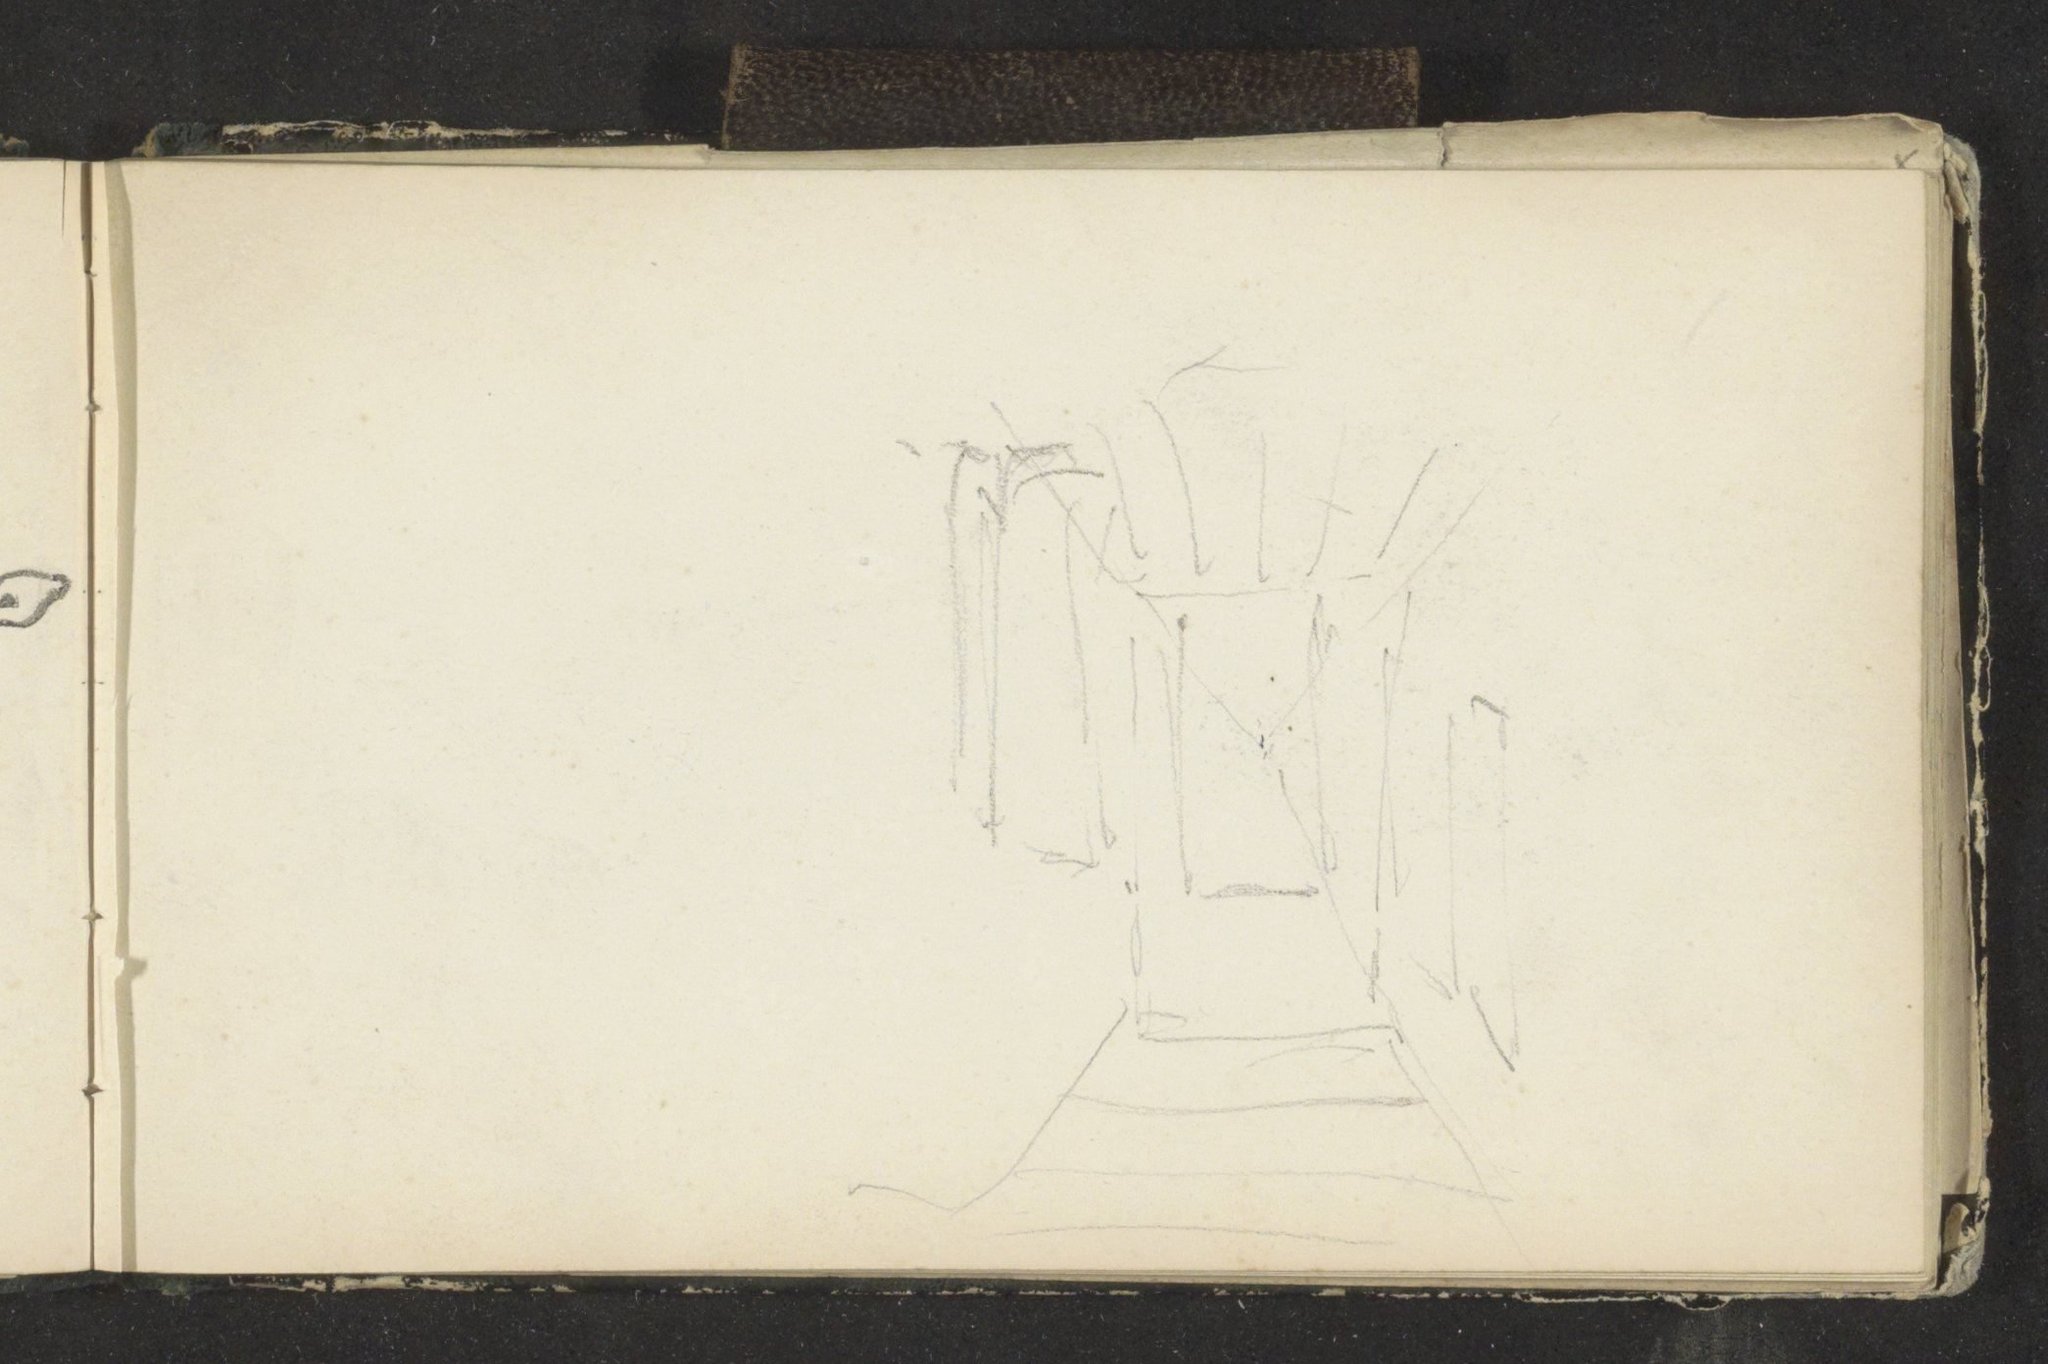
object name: sketchbook leaf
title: Gang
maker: maria vos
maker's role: draughtsman, painter, print maker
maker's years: 1824-1906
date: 1834-1906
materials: paper, pencil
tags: corridor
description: Blad 25 recto uit een schetsboek met 46 bladen.